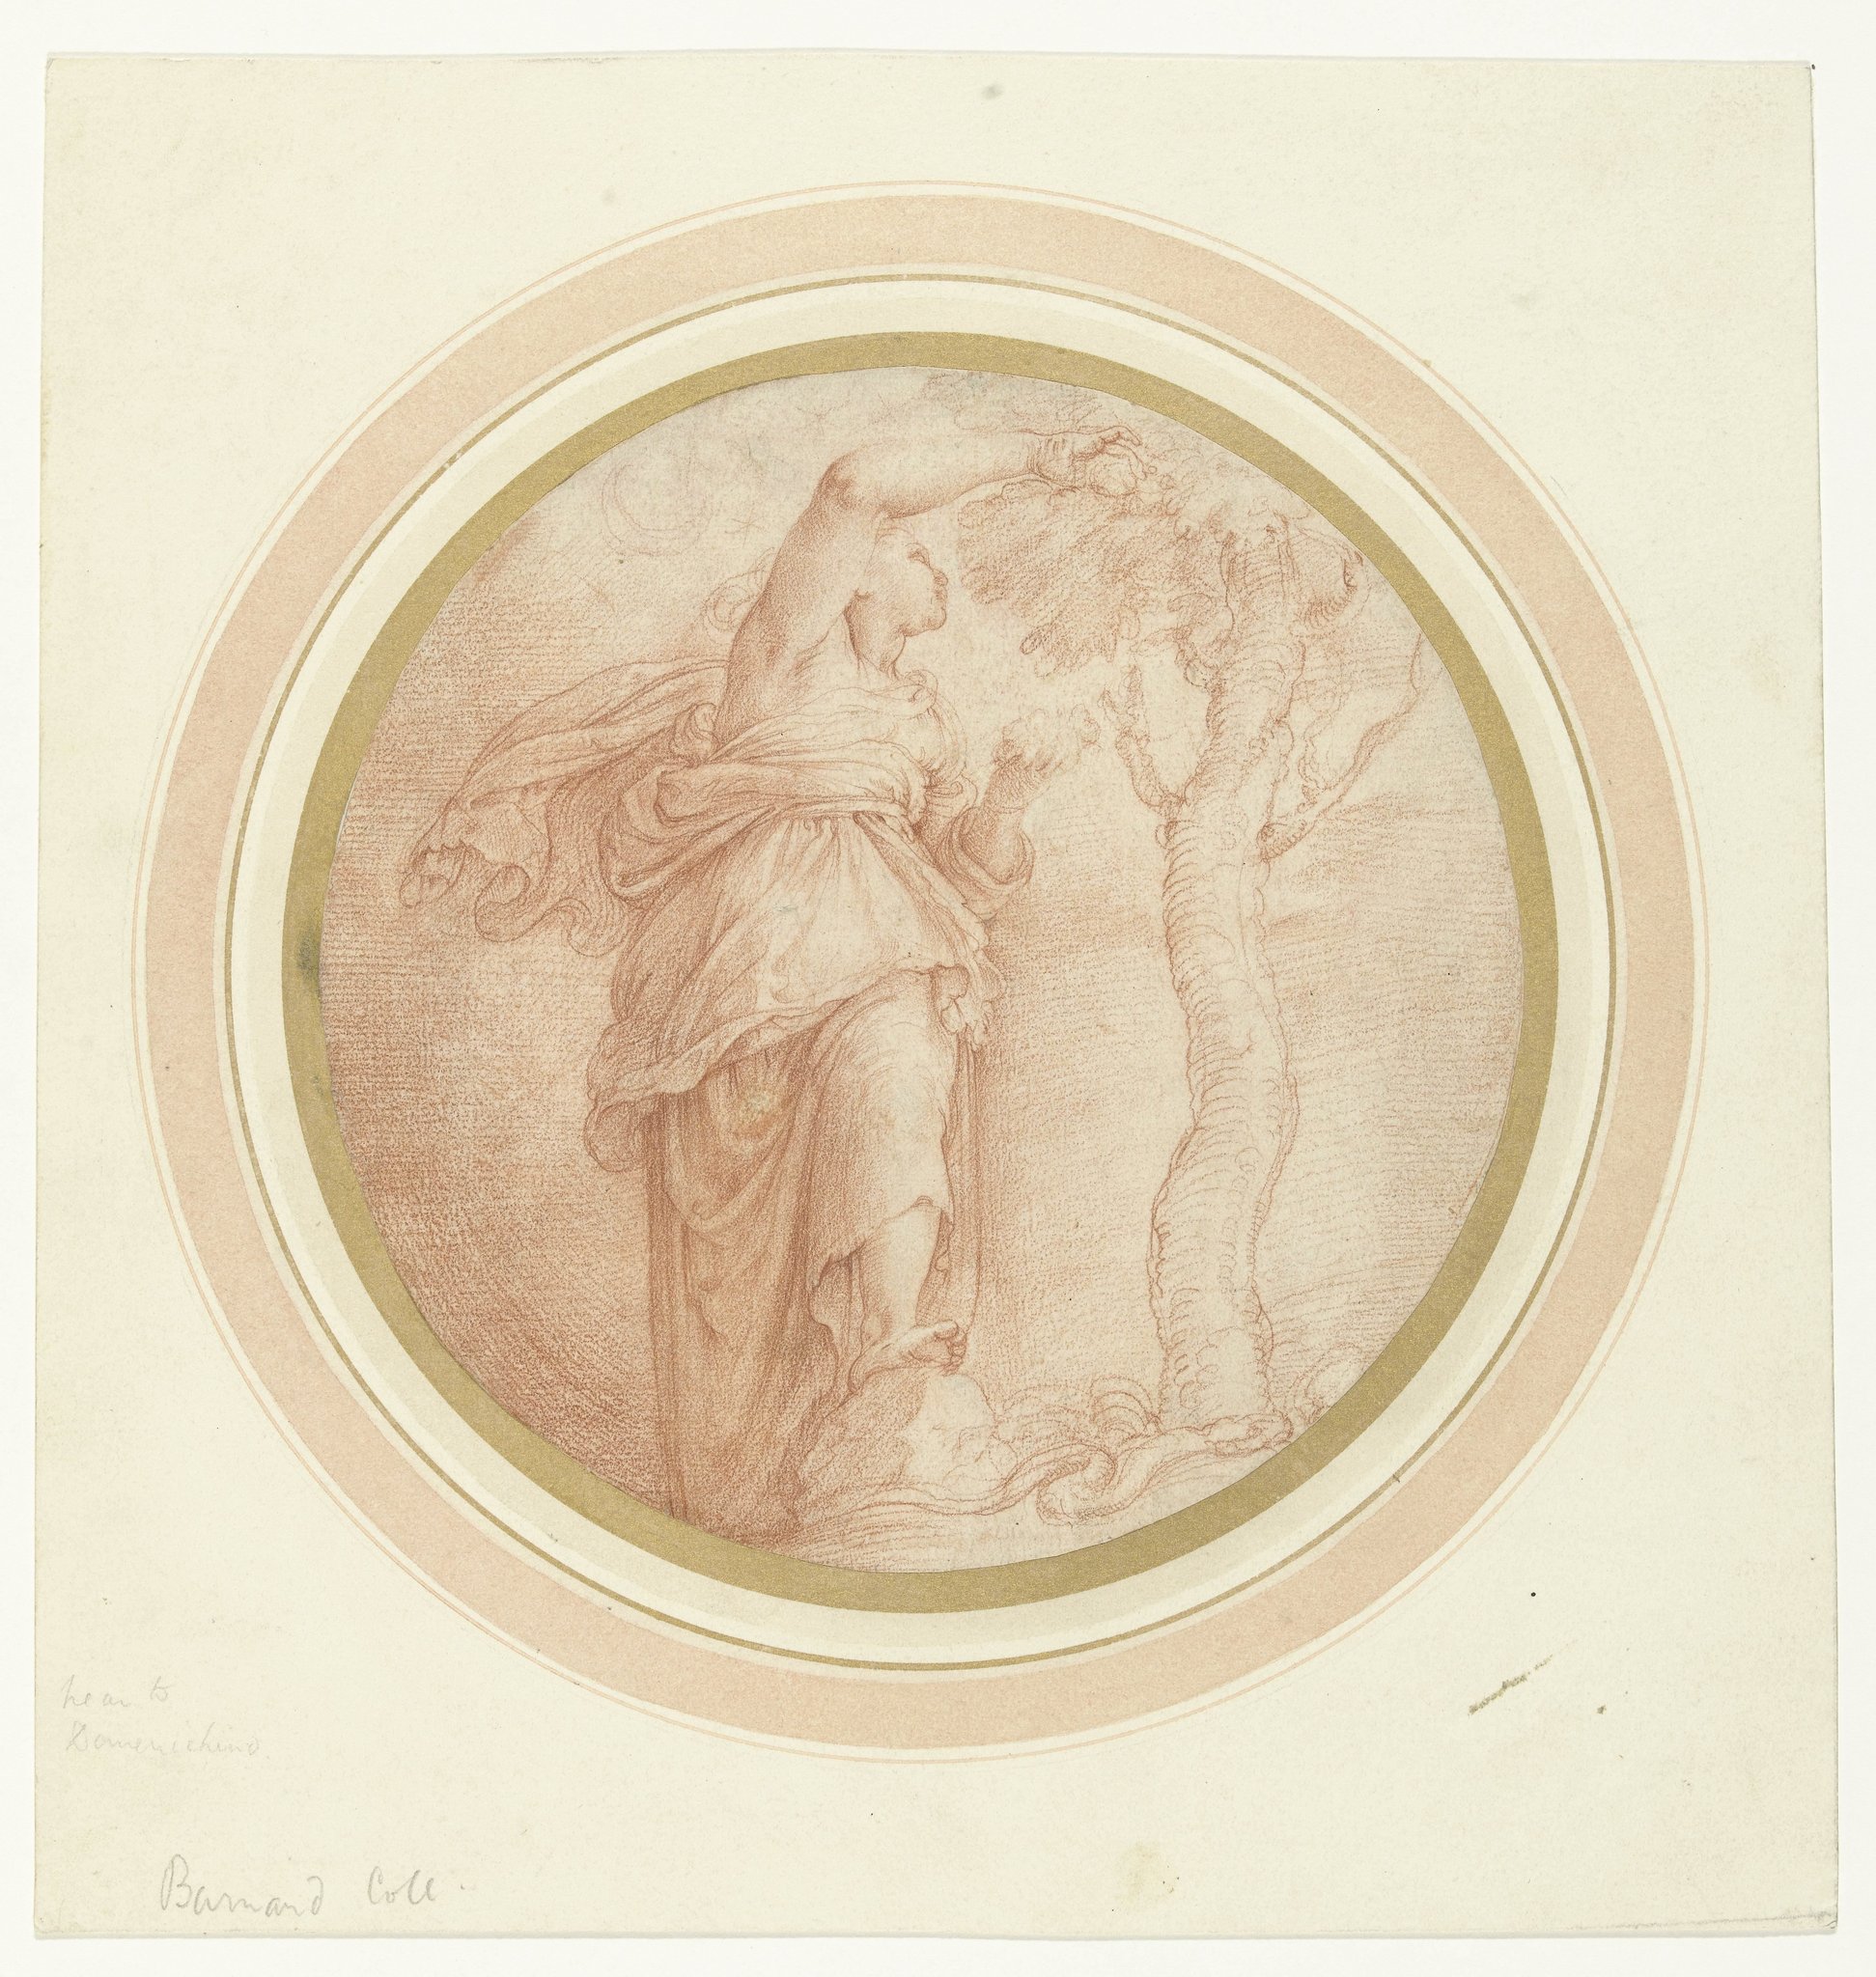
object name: drawing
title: Studie voor Eva, die de appel plukt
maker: battista franco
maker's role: draughtsman, painter, print maker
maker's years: 1510-1561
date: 1555-1561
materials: chalk, paper